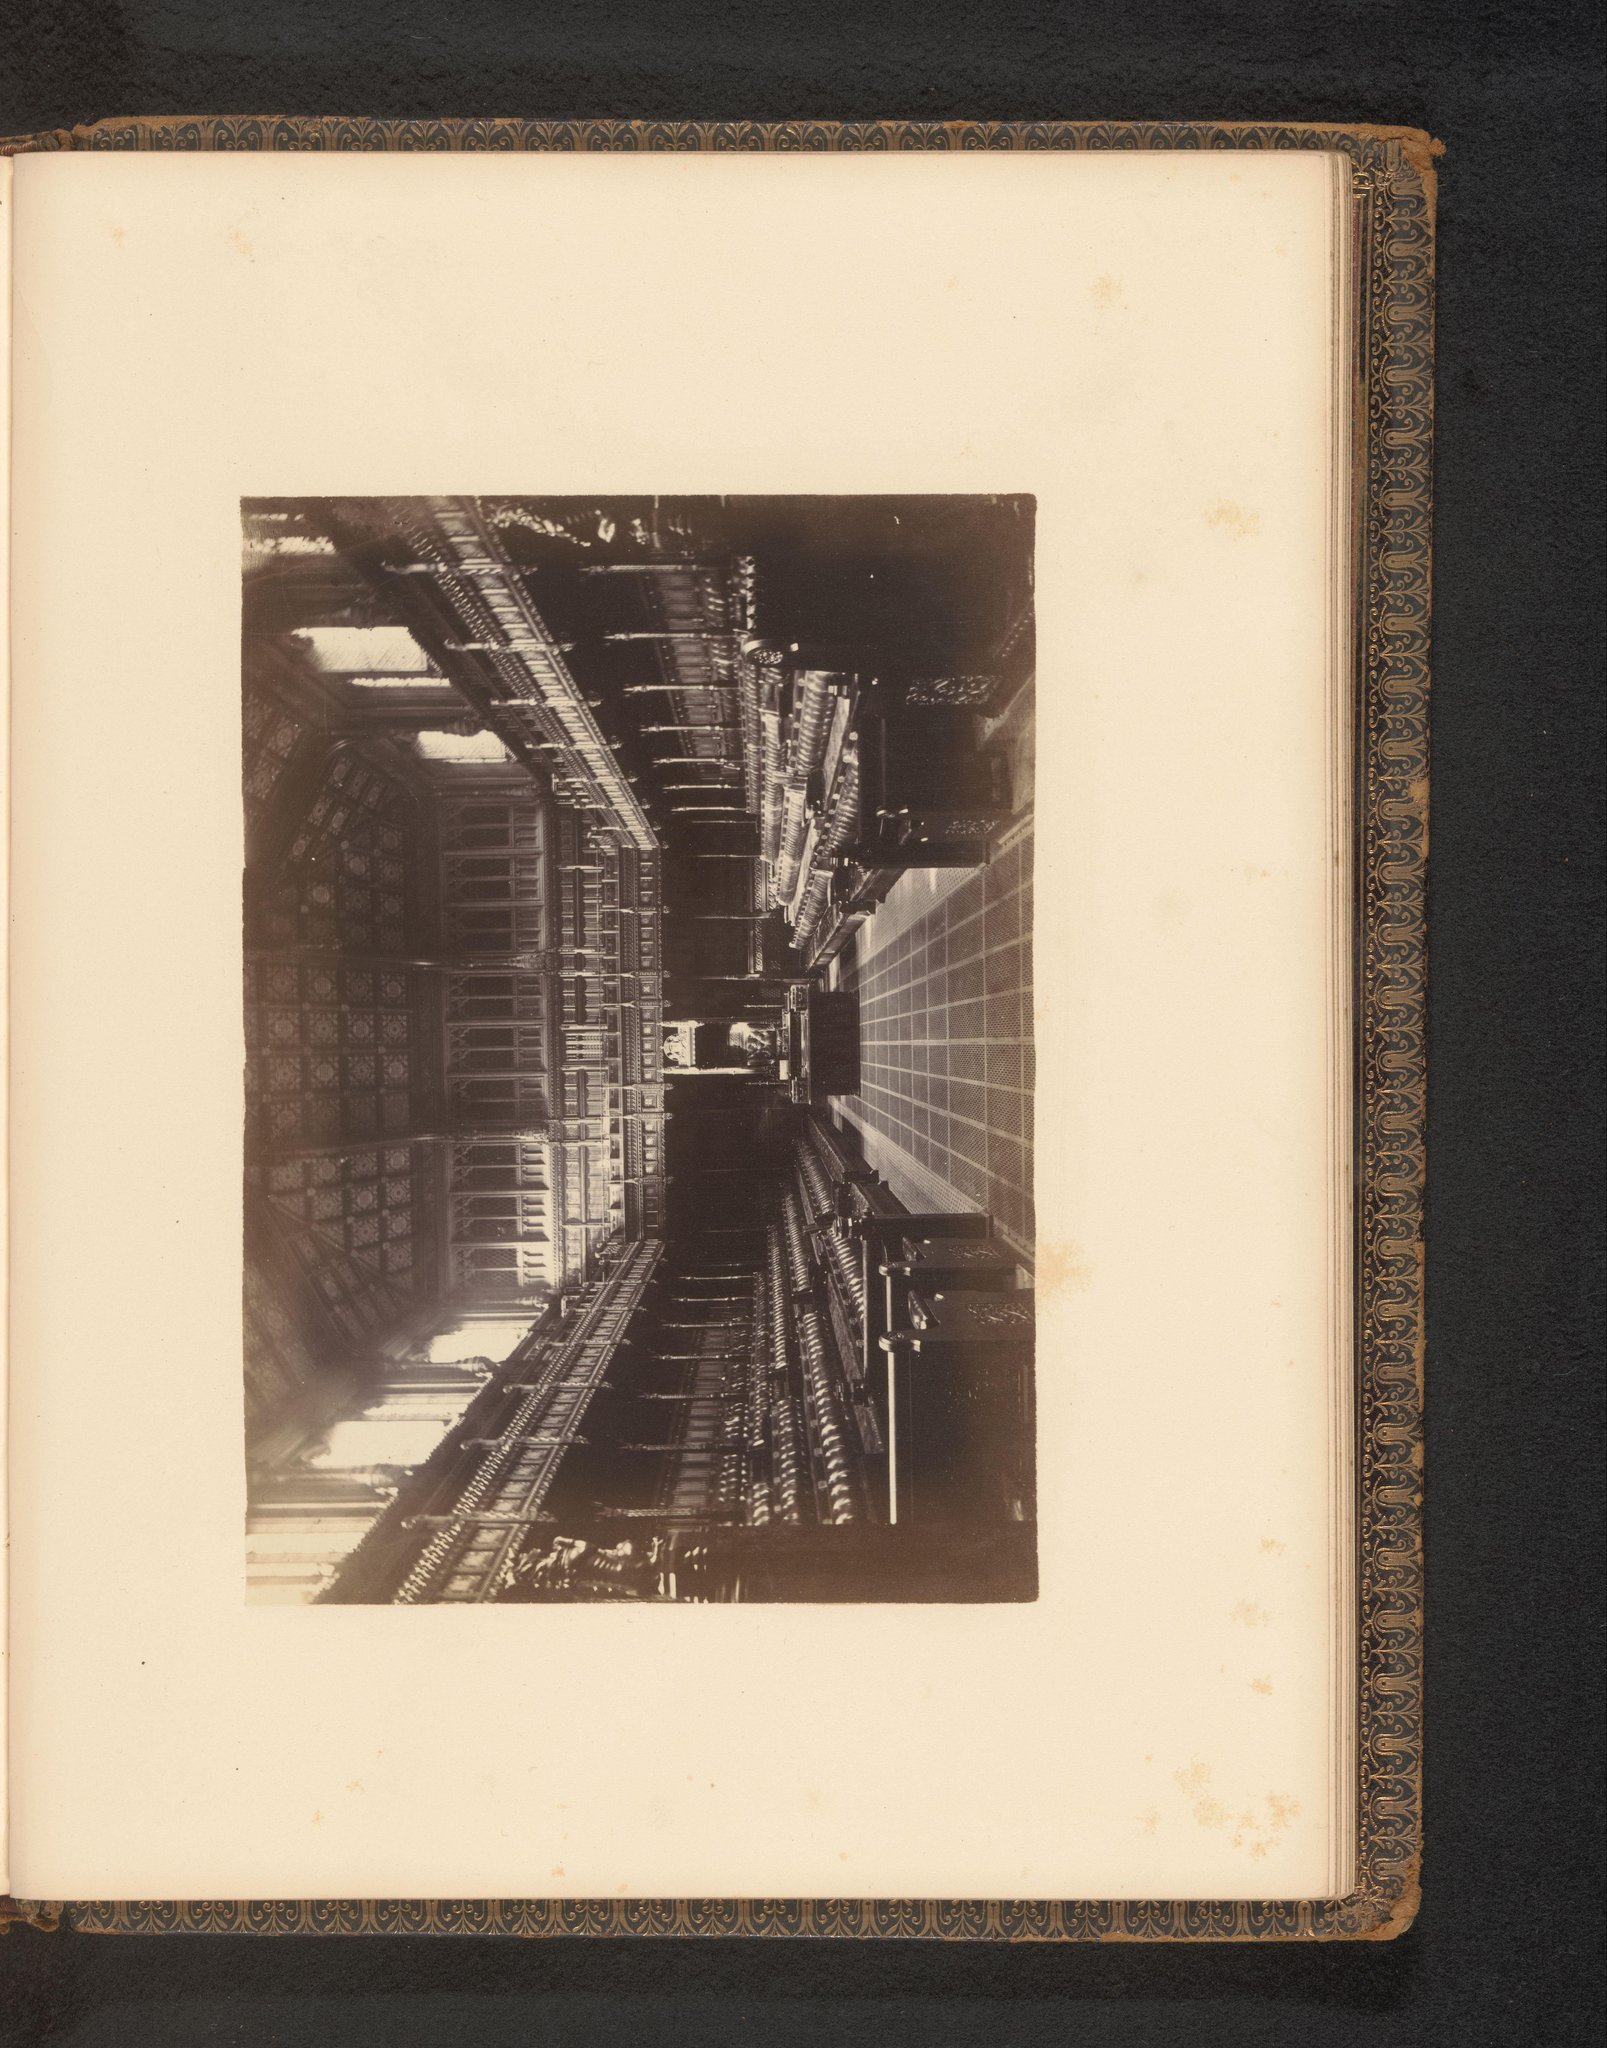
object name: page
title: Interieur van House of Commons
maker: john harrington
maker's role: fotograaf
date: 1864-1869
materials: photographic support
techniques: albumen print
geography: london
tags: palace - aa - civic architecture: inside